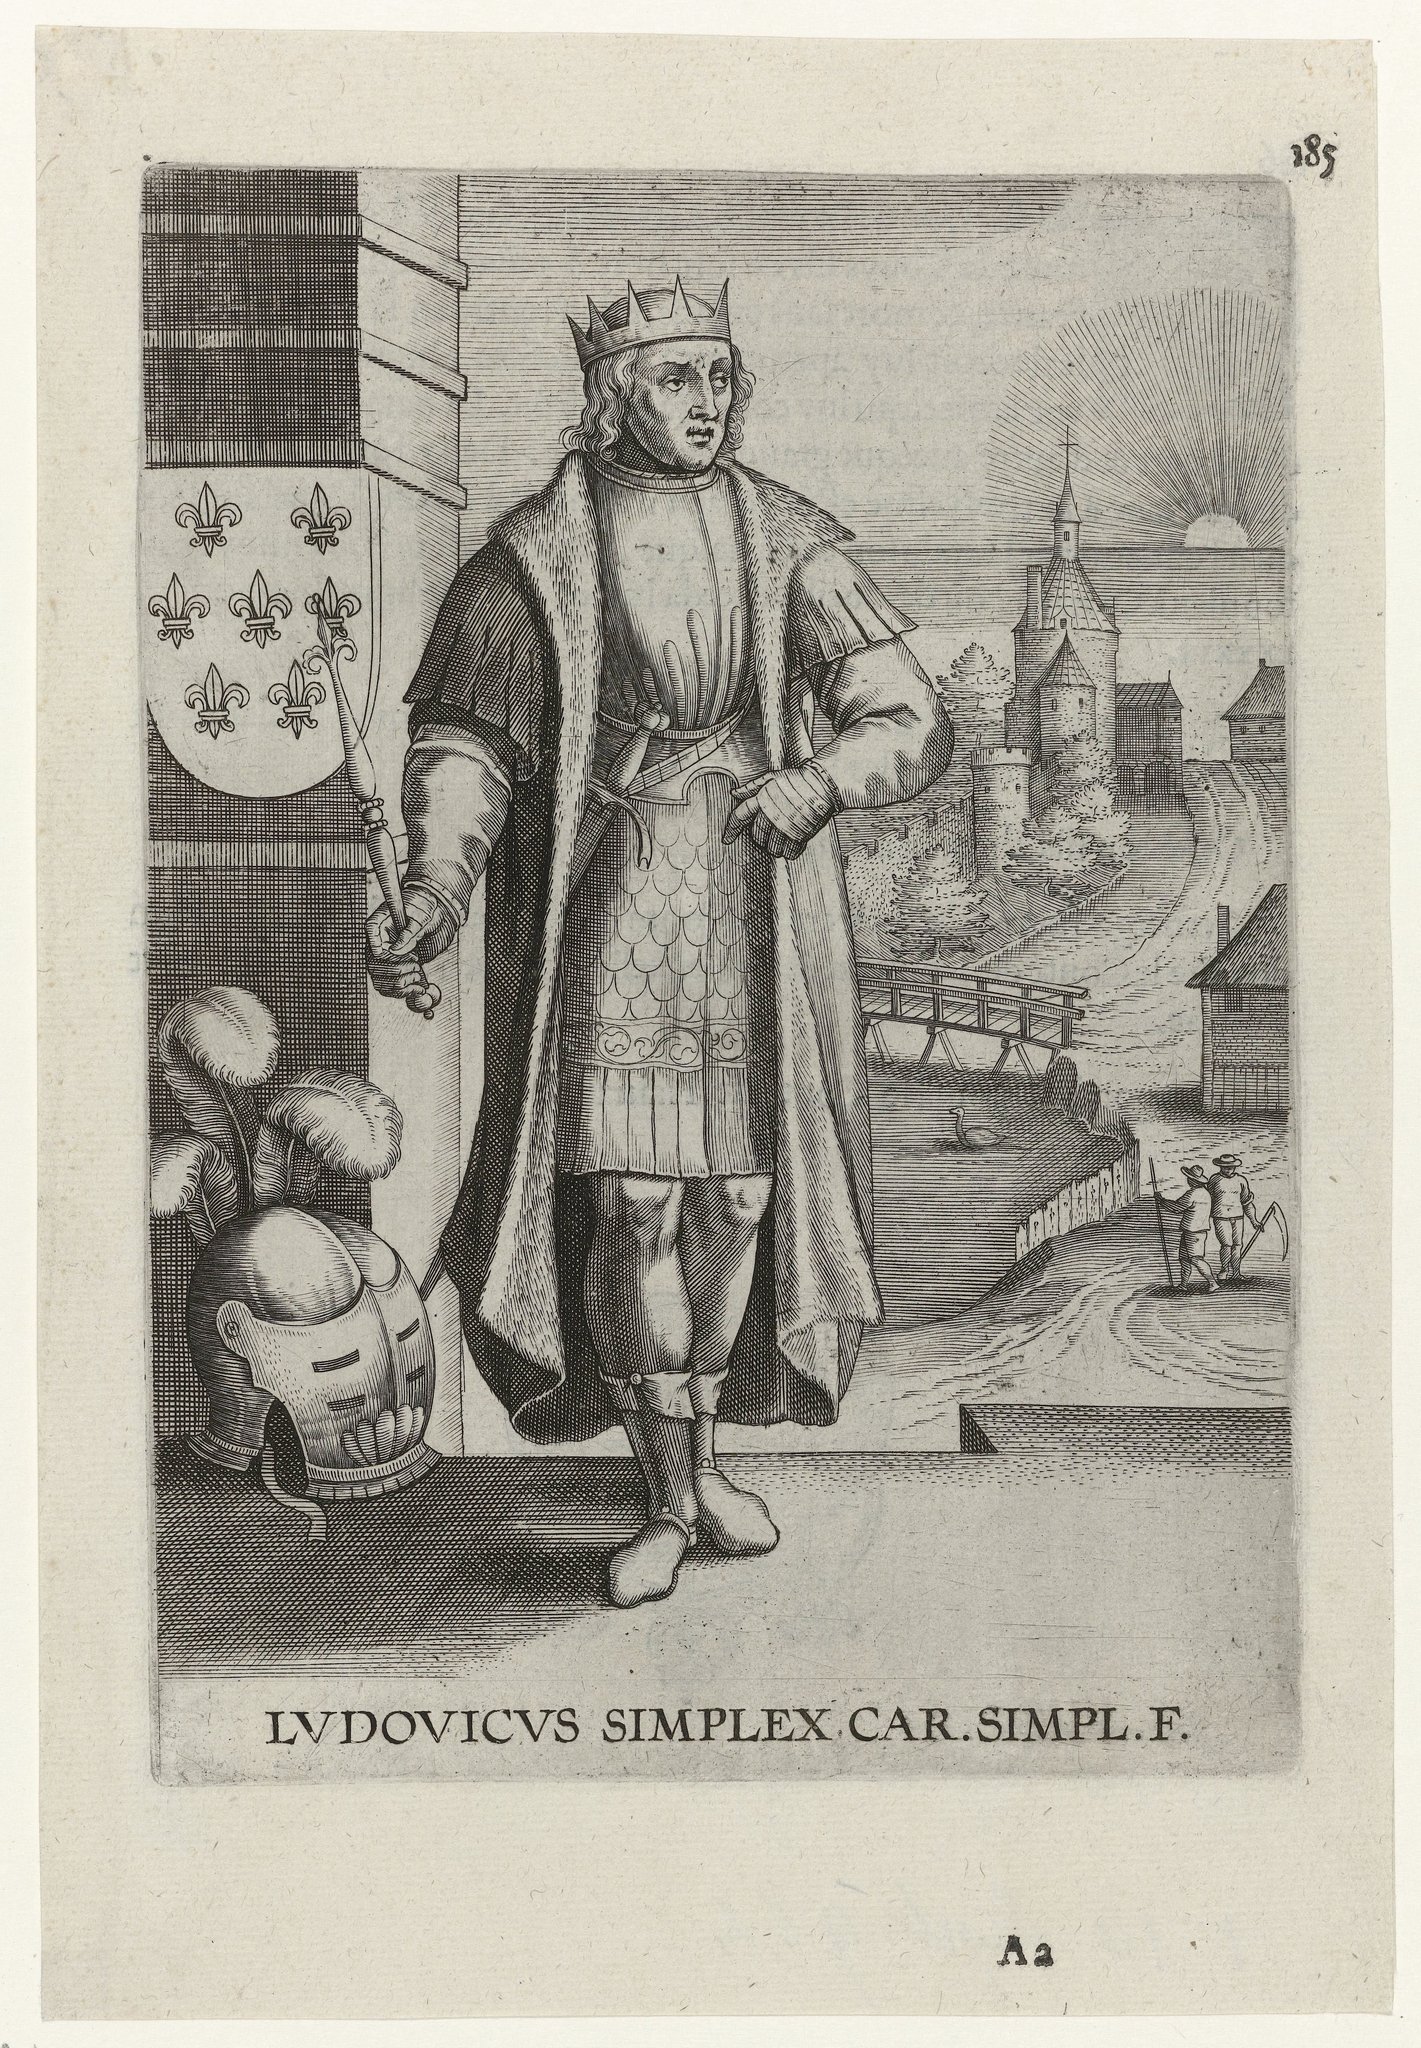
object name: print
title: Lvdovicvs car simpl. F.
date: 1603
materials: paper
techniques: engraving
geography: antwerp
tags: london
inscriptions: collector's mark: Lugt 2228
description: Lodewijk IV de Eenvoudige, koning van Frankrijk. Naast hem het wapenschild van Frankrijk. De prent dient als een illustratie bij een boek over de geschiedenis van de graven van Brabant en heeft het folionummer Aa.